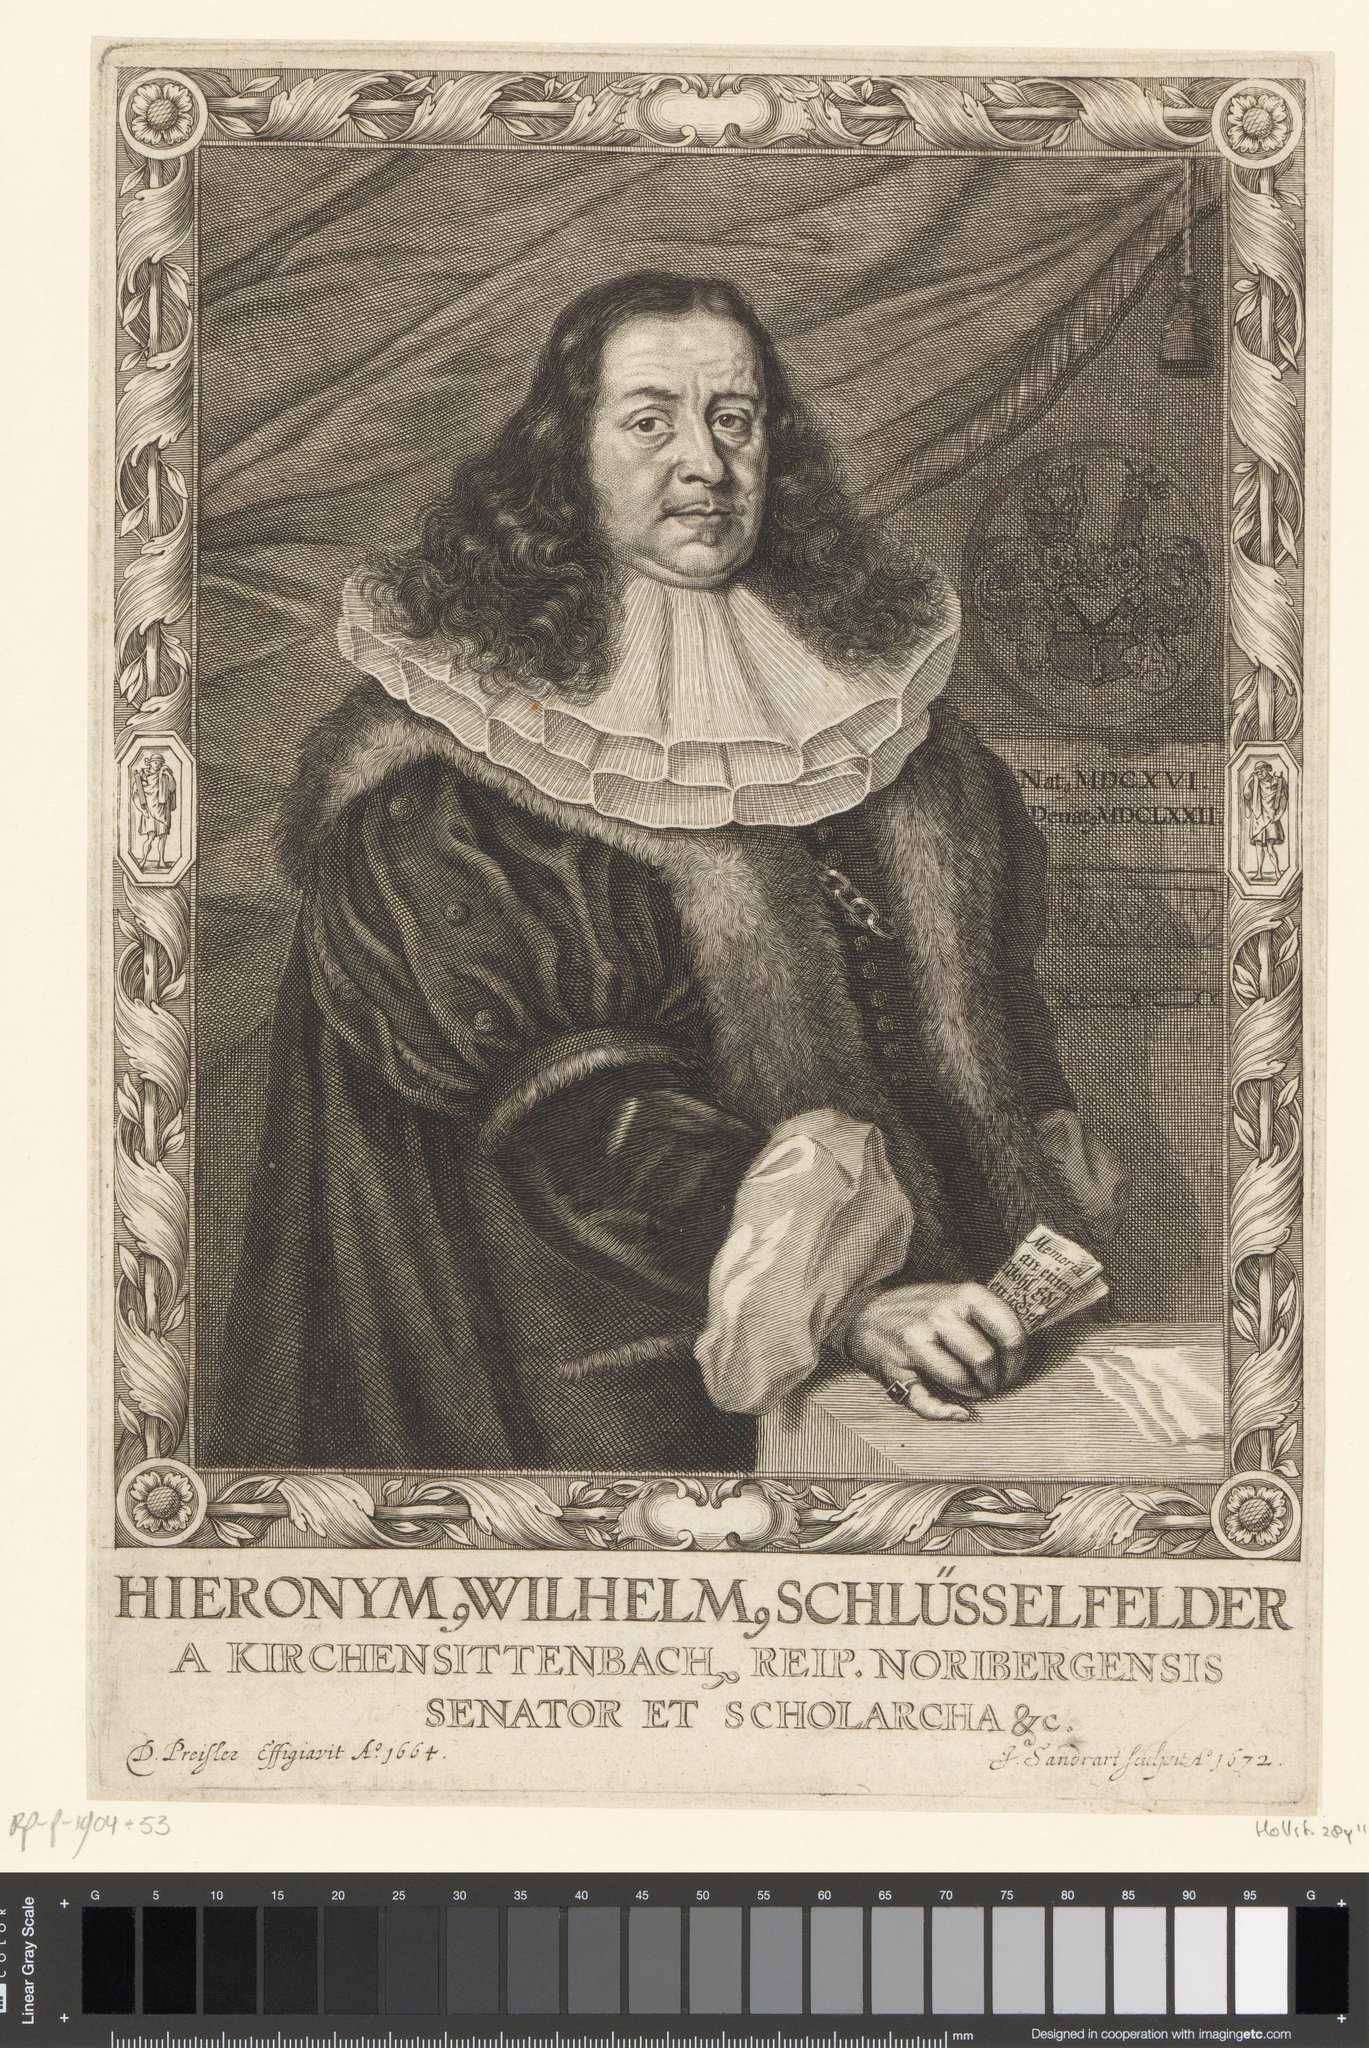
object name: print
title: Portret van Hieronymus Wilhelm Schlüsselfelder von Kirchensittenbach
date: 1672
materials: paper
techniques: engraving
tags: historical persons, armorial bearing, heraldry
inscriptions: collector's mark: Lugt 2228